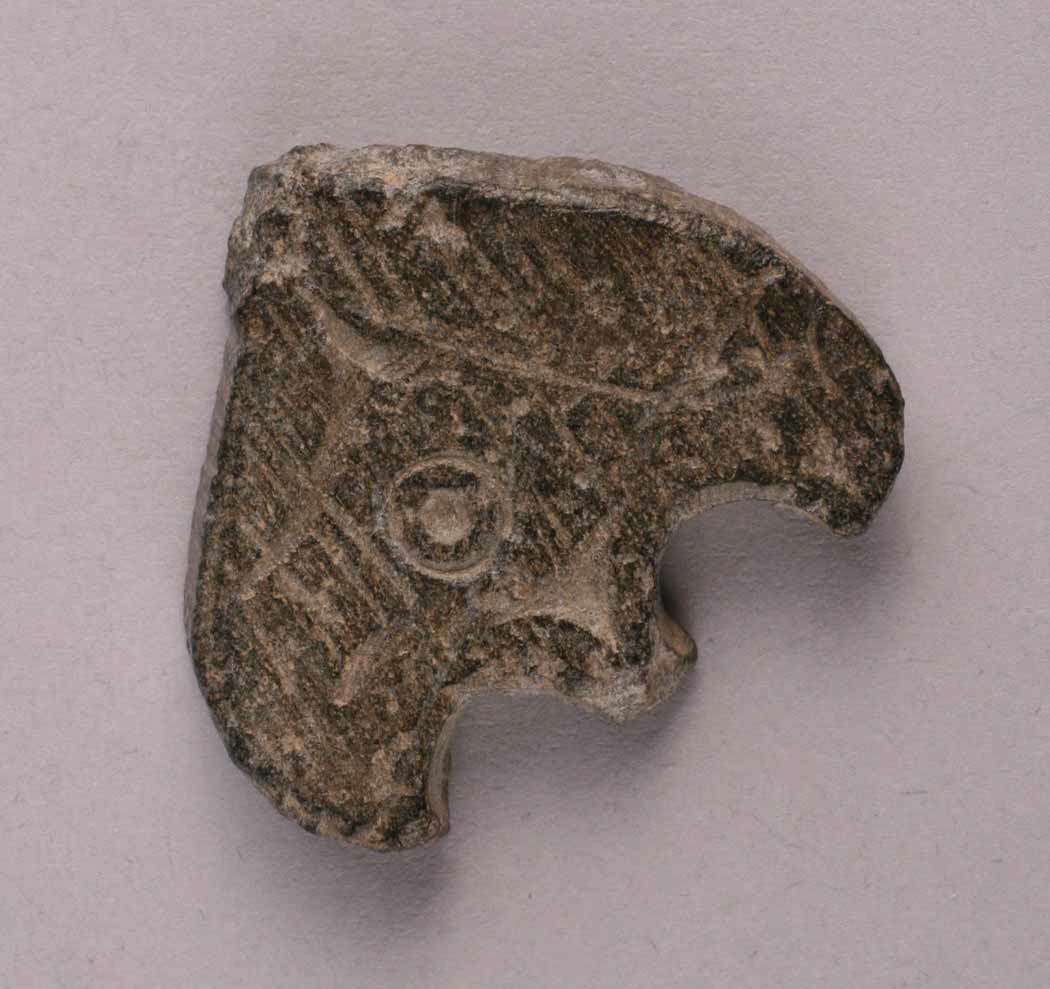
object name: pendant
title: Possibly a Pendant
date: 701-1300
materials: stone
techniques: carving, incising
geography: iran